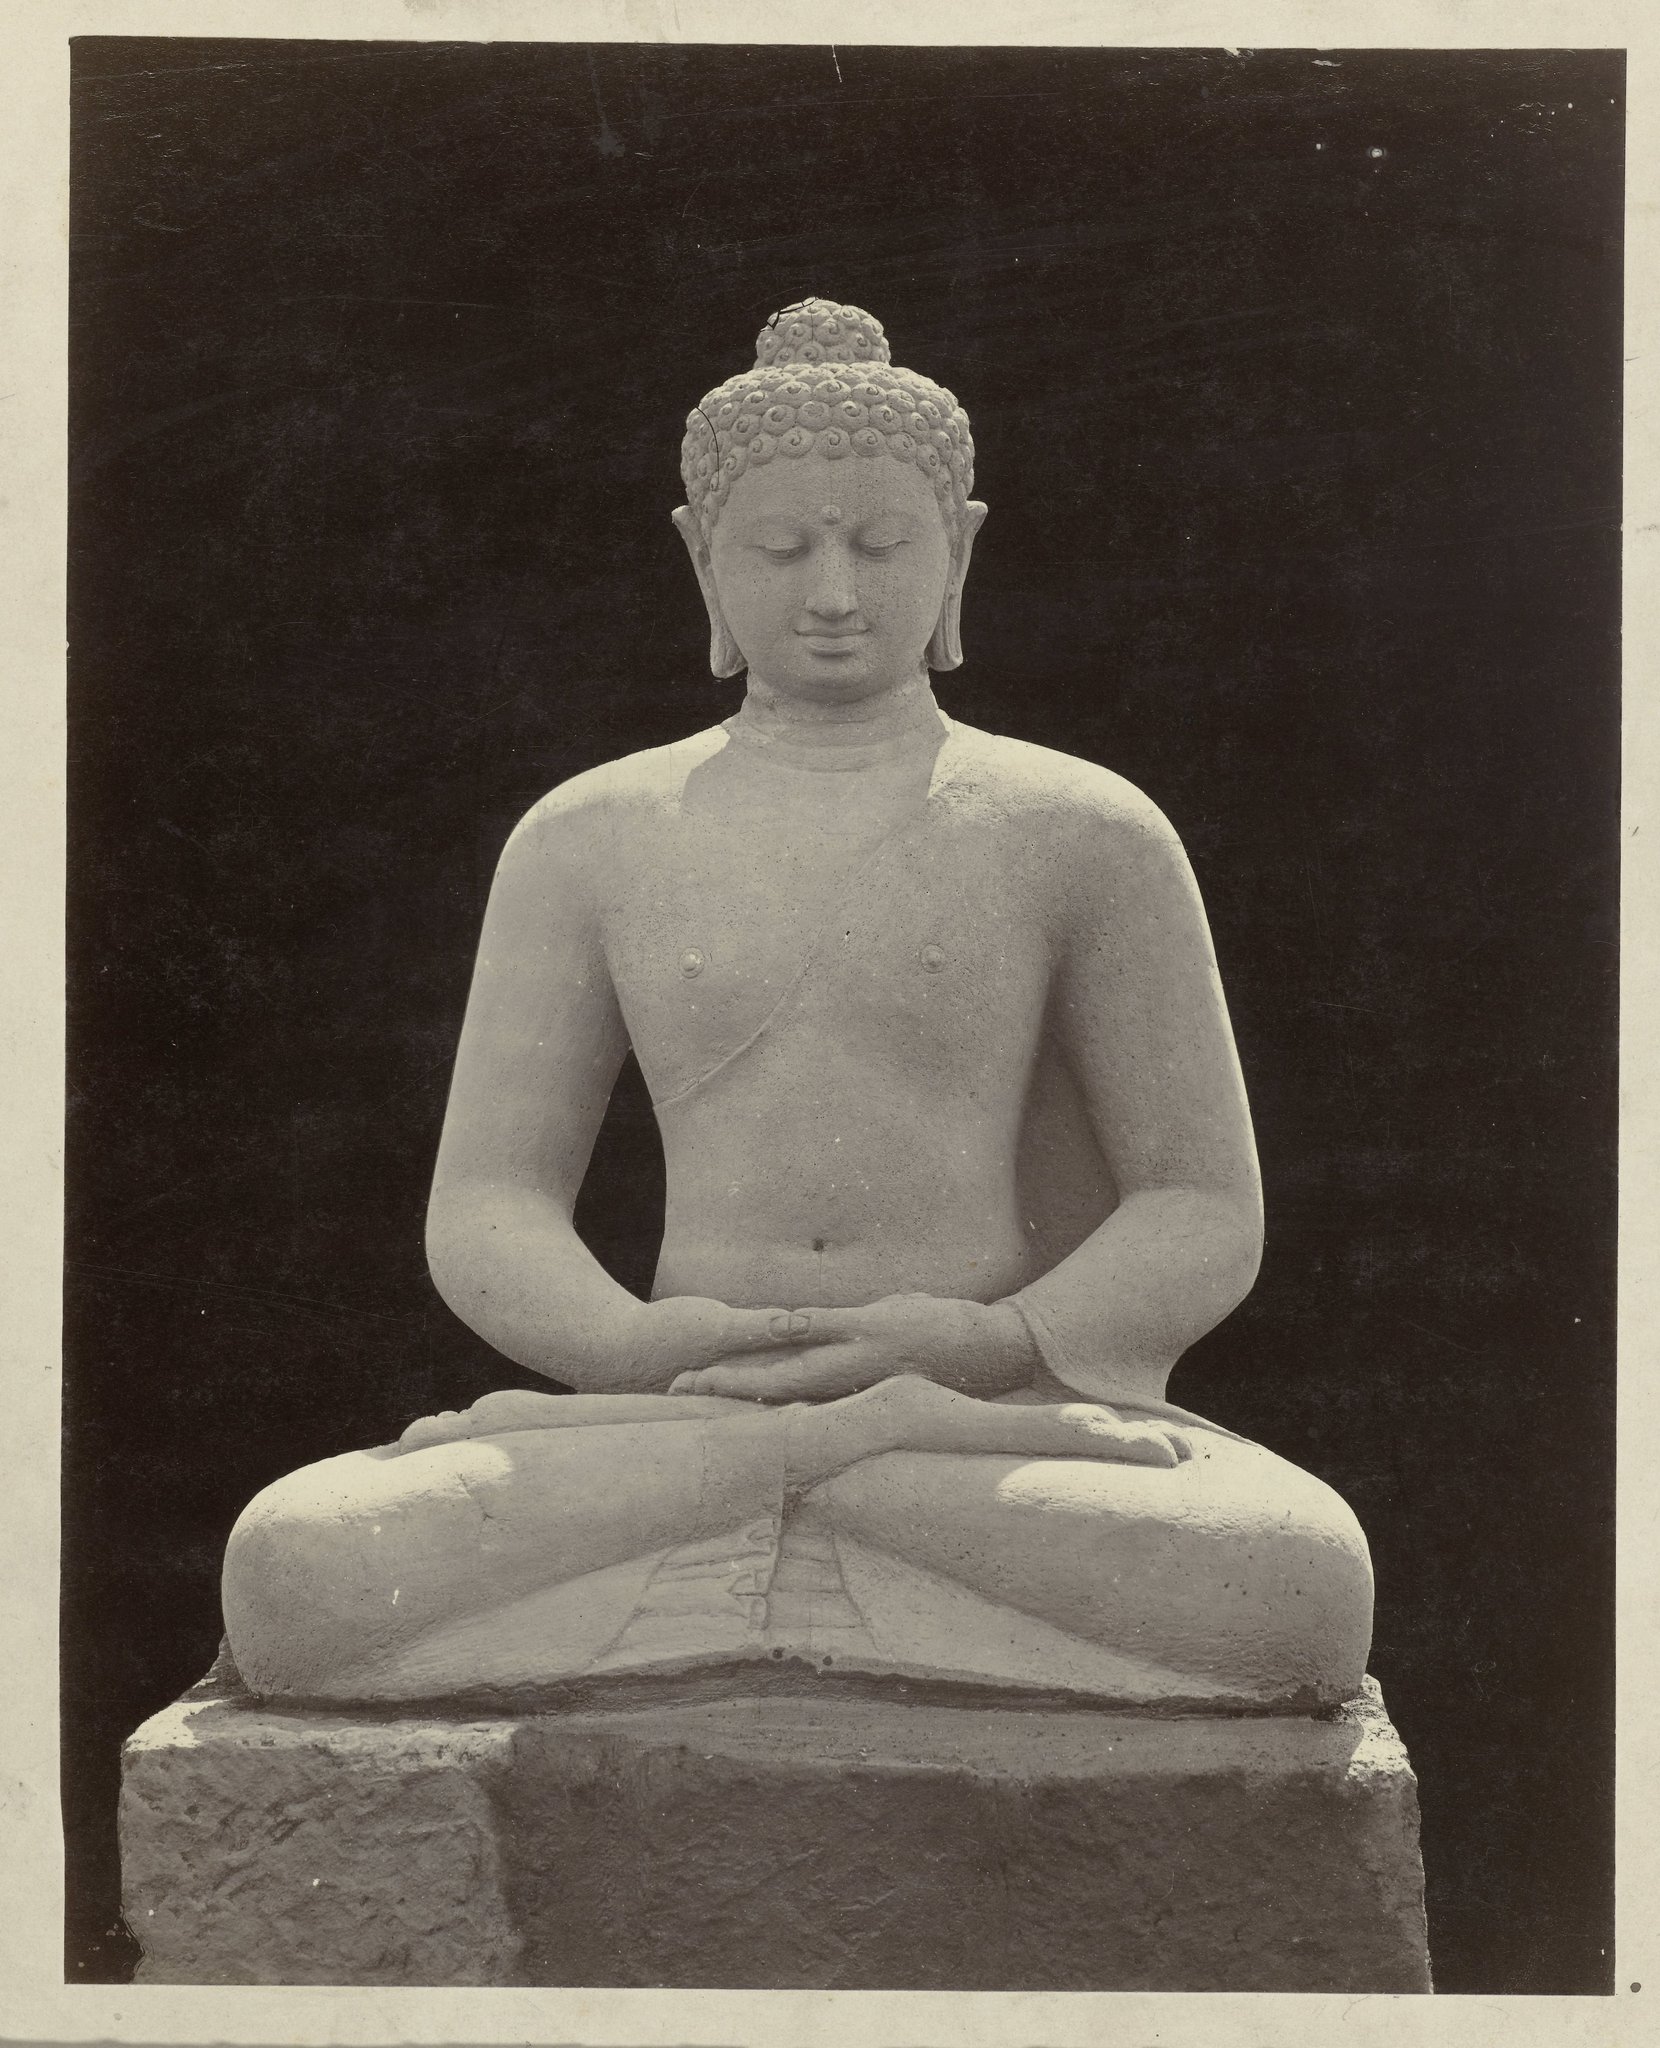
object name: photograph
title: Idem Westzijde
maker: isidore kinsbergen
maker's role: fotograaf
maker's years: 1821-1905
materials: cardboard, paper, photographic support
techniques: albumen print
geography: java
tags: borobudur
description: Buddha sculpture from a niche at the west side displaying the dhyanamudra. Borobudur village, Magelang district, Central Java province, 778-824 AD.